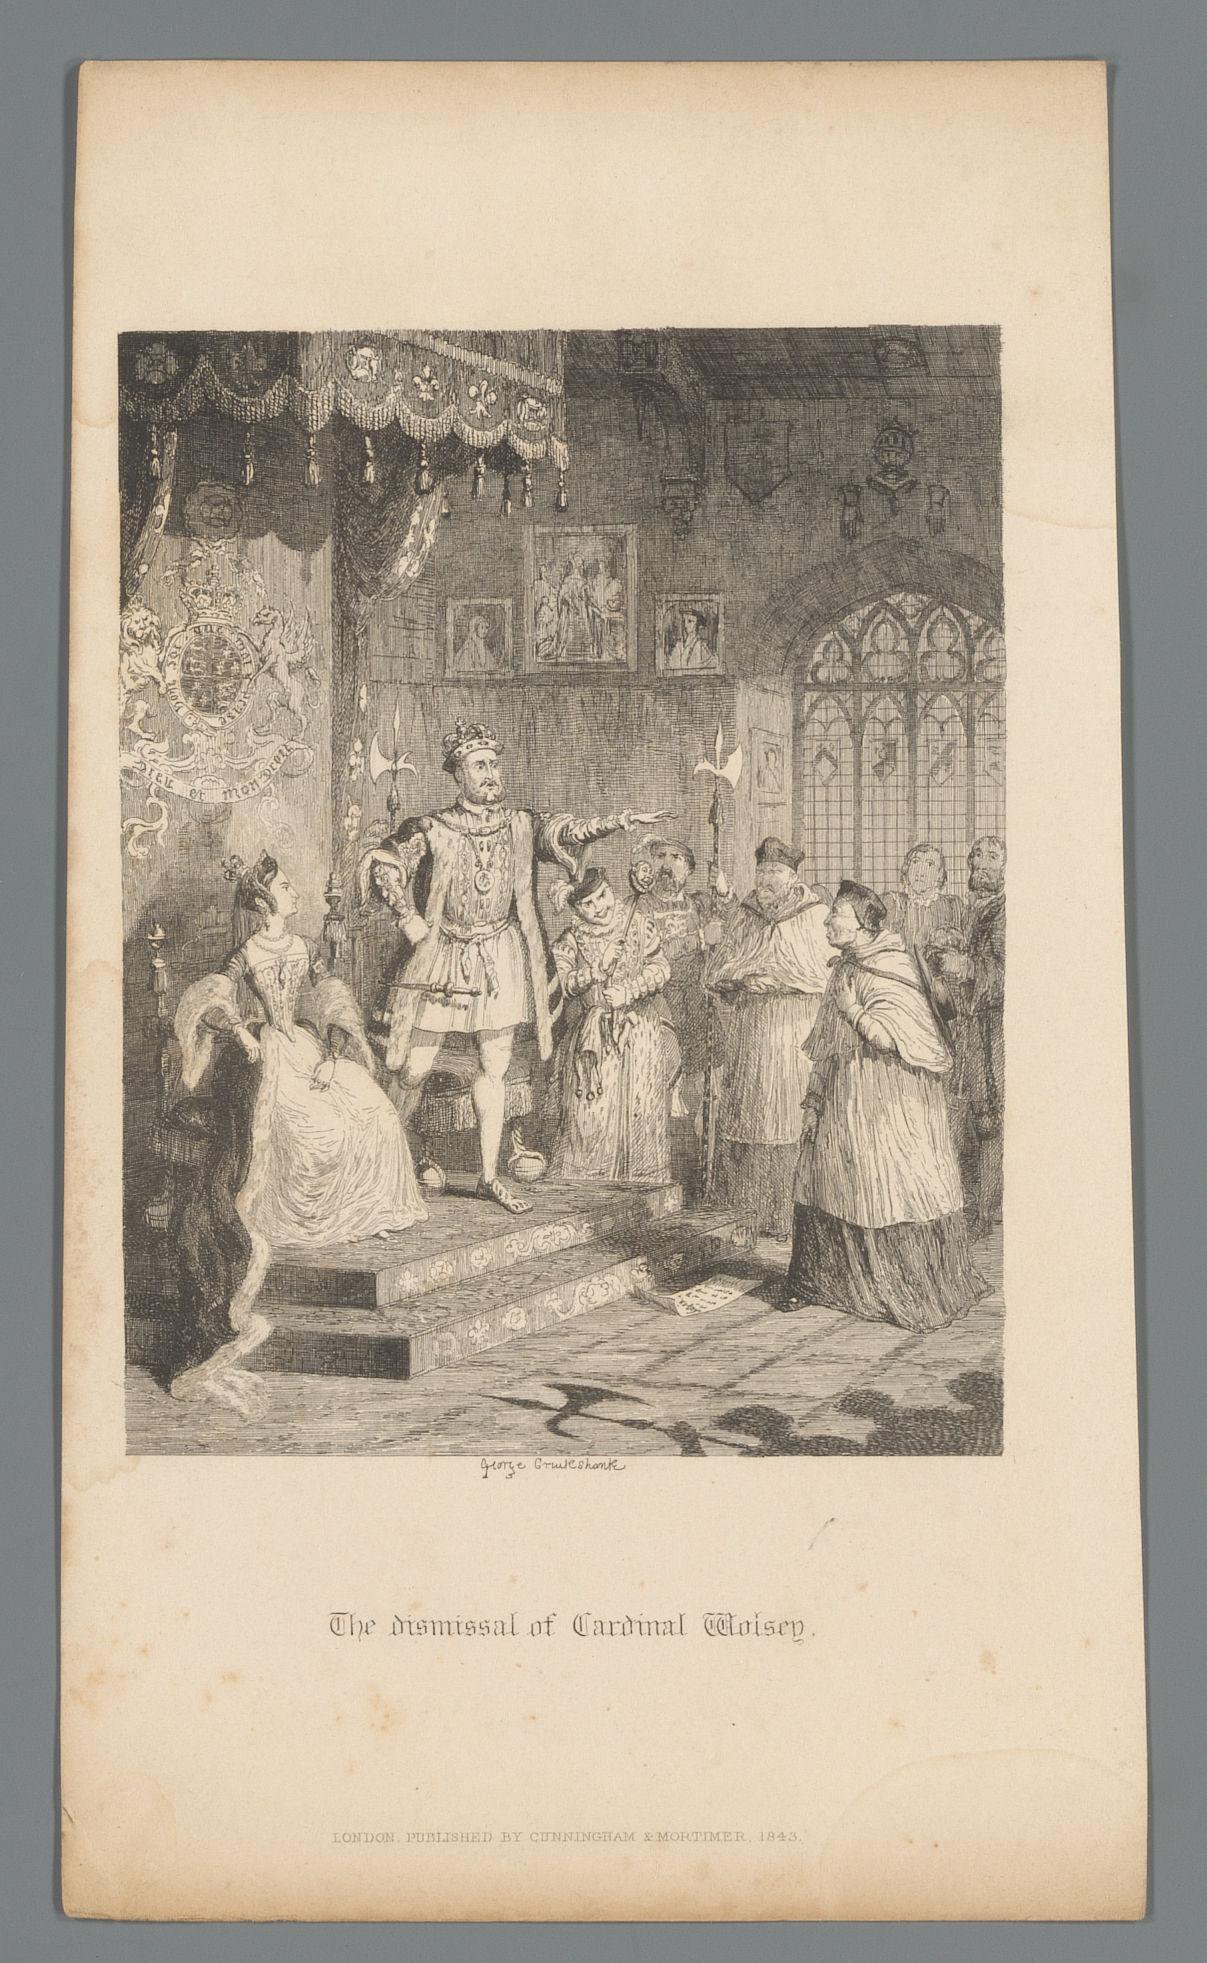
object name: book illustration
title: Kardinaal Wolsey door de koning weggestuurd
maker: george cruikshank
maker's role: painter, print maker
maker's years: 1792-1878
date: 1843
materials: paper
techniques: etching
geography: england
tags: political caricatures and satires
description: Kardinaal Thomas Wolsey door koning Hendrik VIII weggestuurd. Illustratie uit een uitgave van "Windsor Castle", van William Ainsworth (1843).